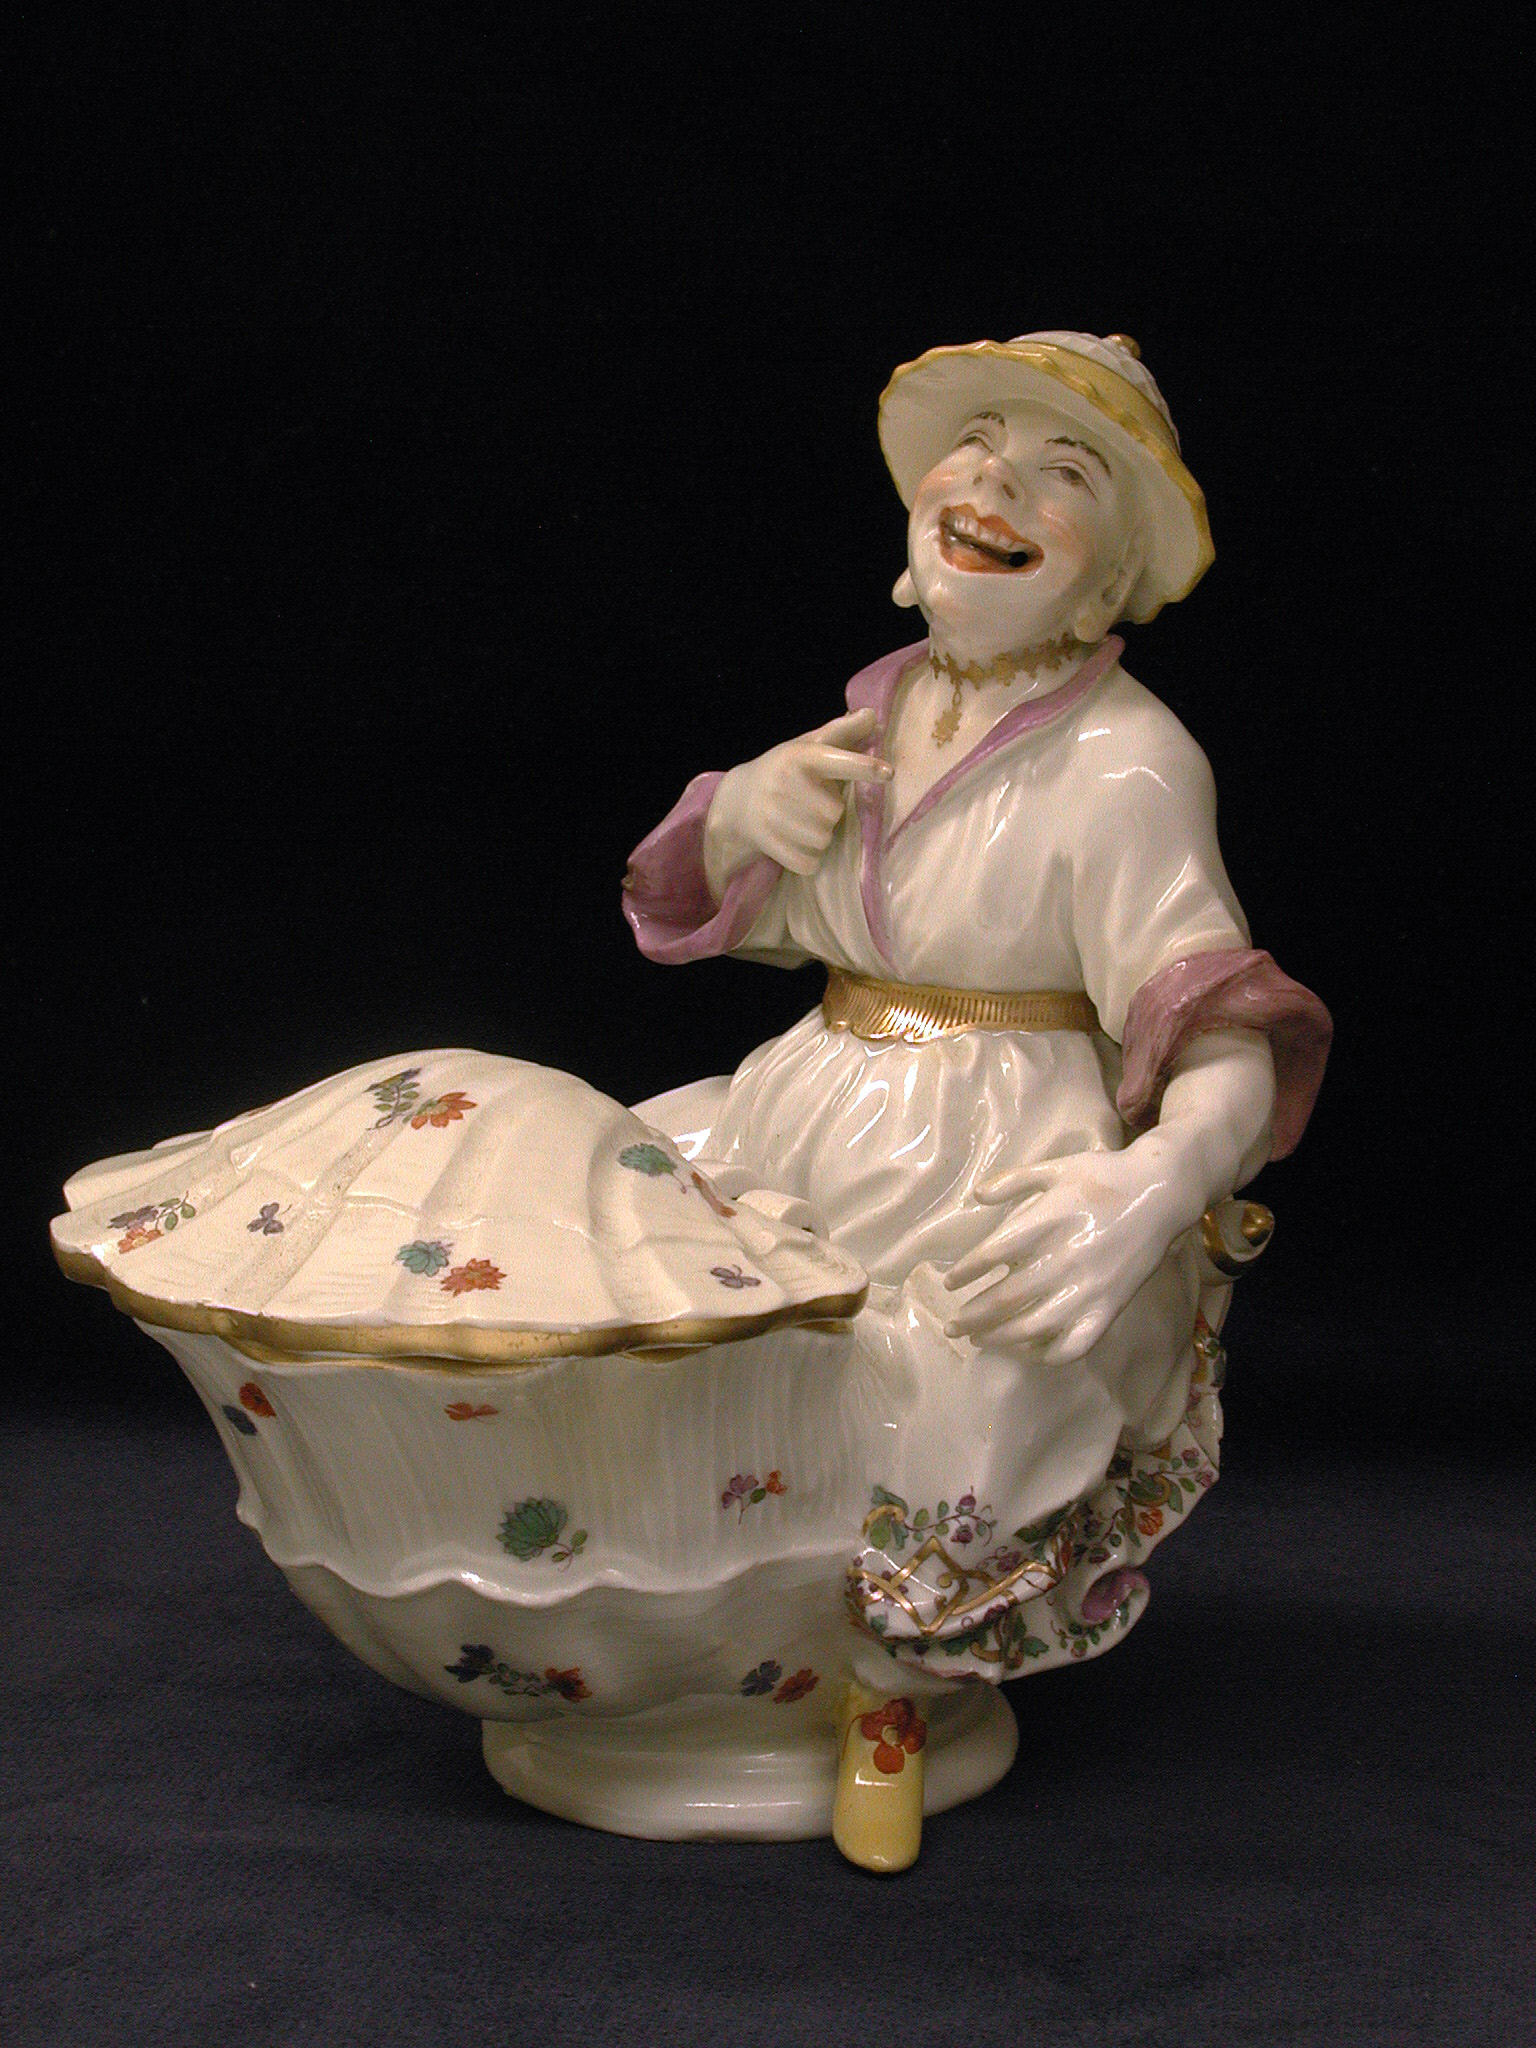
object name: spice box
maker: meissen manufactory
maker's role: manufactory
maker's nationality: german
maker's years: 1710-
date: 1737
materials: hard paste porcelain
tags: women,flowers